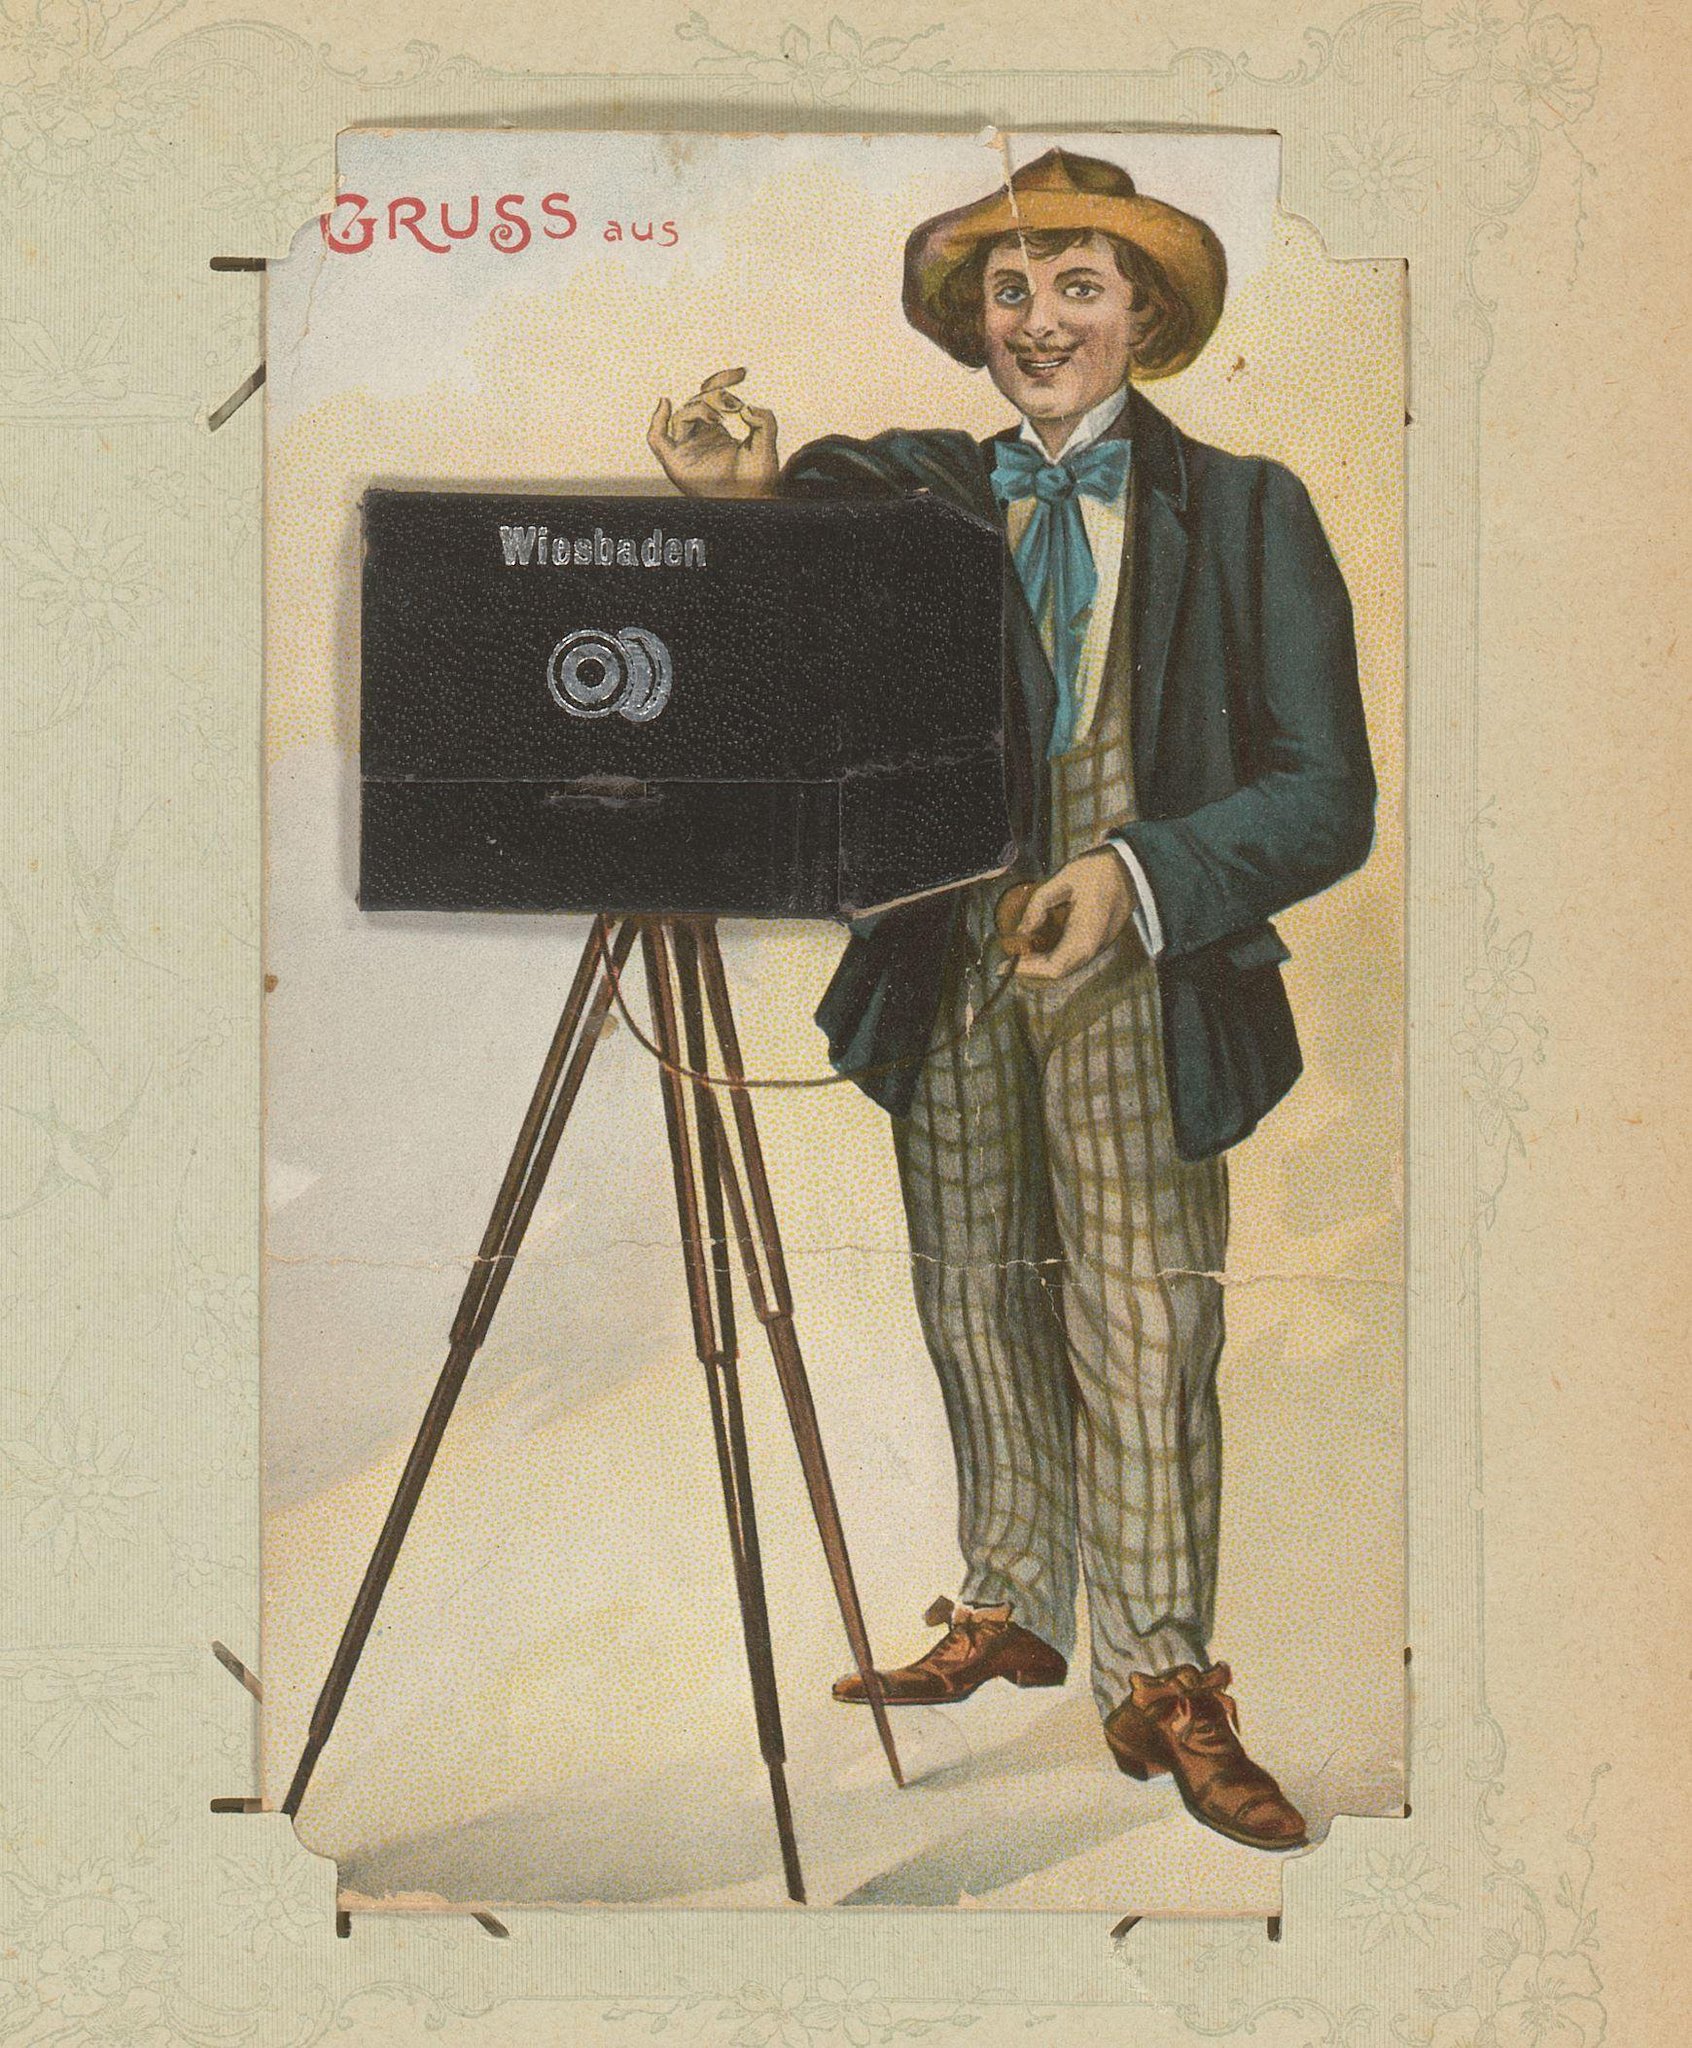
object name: photomechanical print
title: Gruss aus Wiesbaden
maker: Anonymous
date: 1900-1950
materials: cardboard, leather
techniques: four-color autotype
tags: adult woman, camera ~ photography, taking photographs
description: Prentbriefkaart waarbij de camera een mapje voor foto's is. Deze prent maakt deel uit van een album.